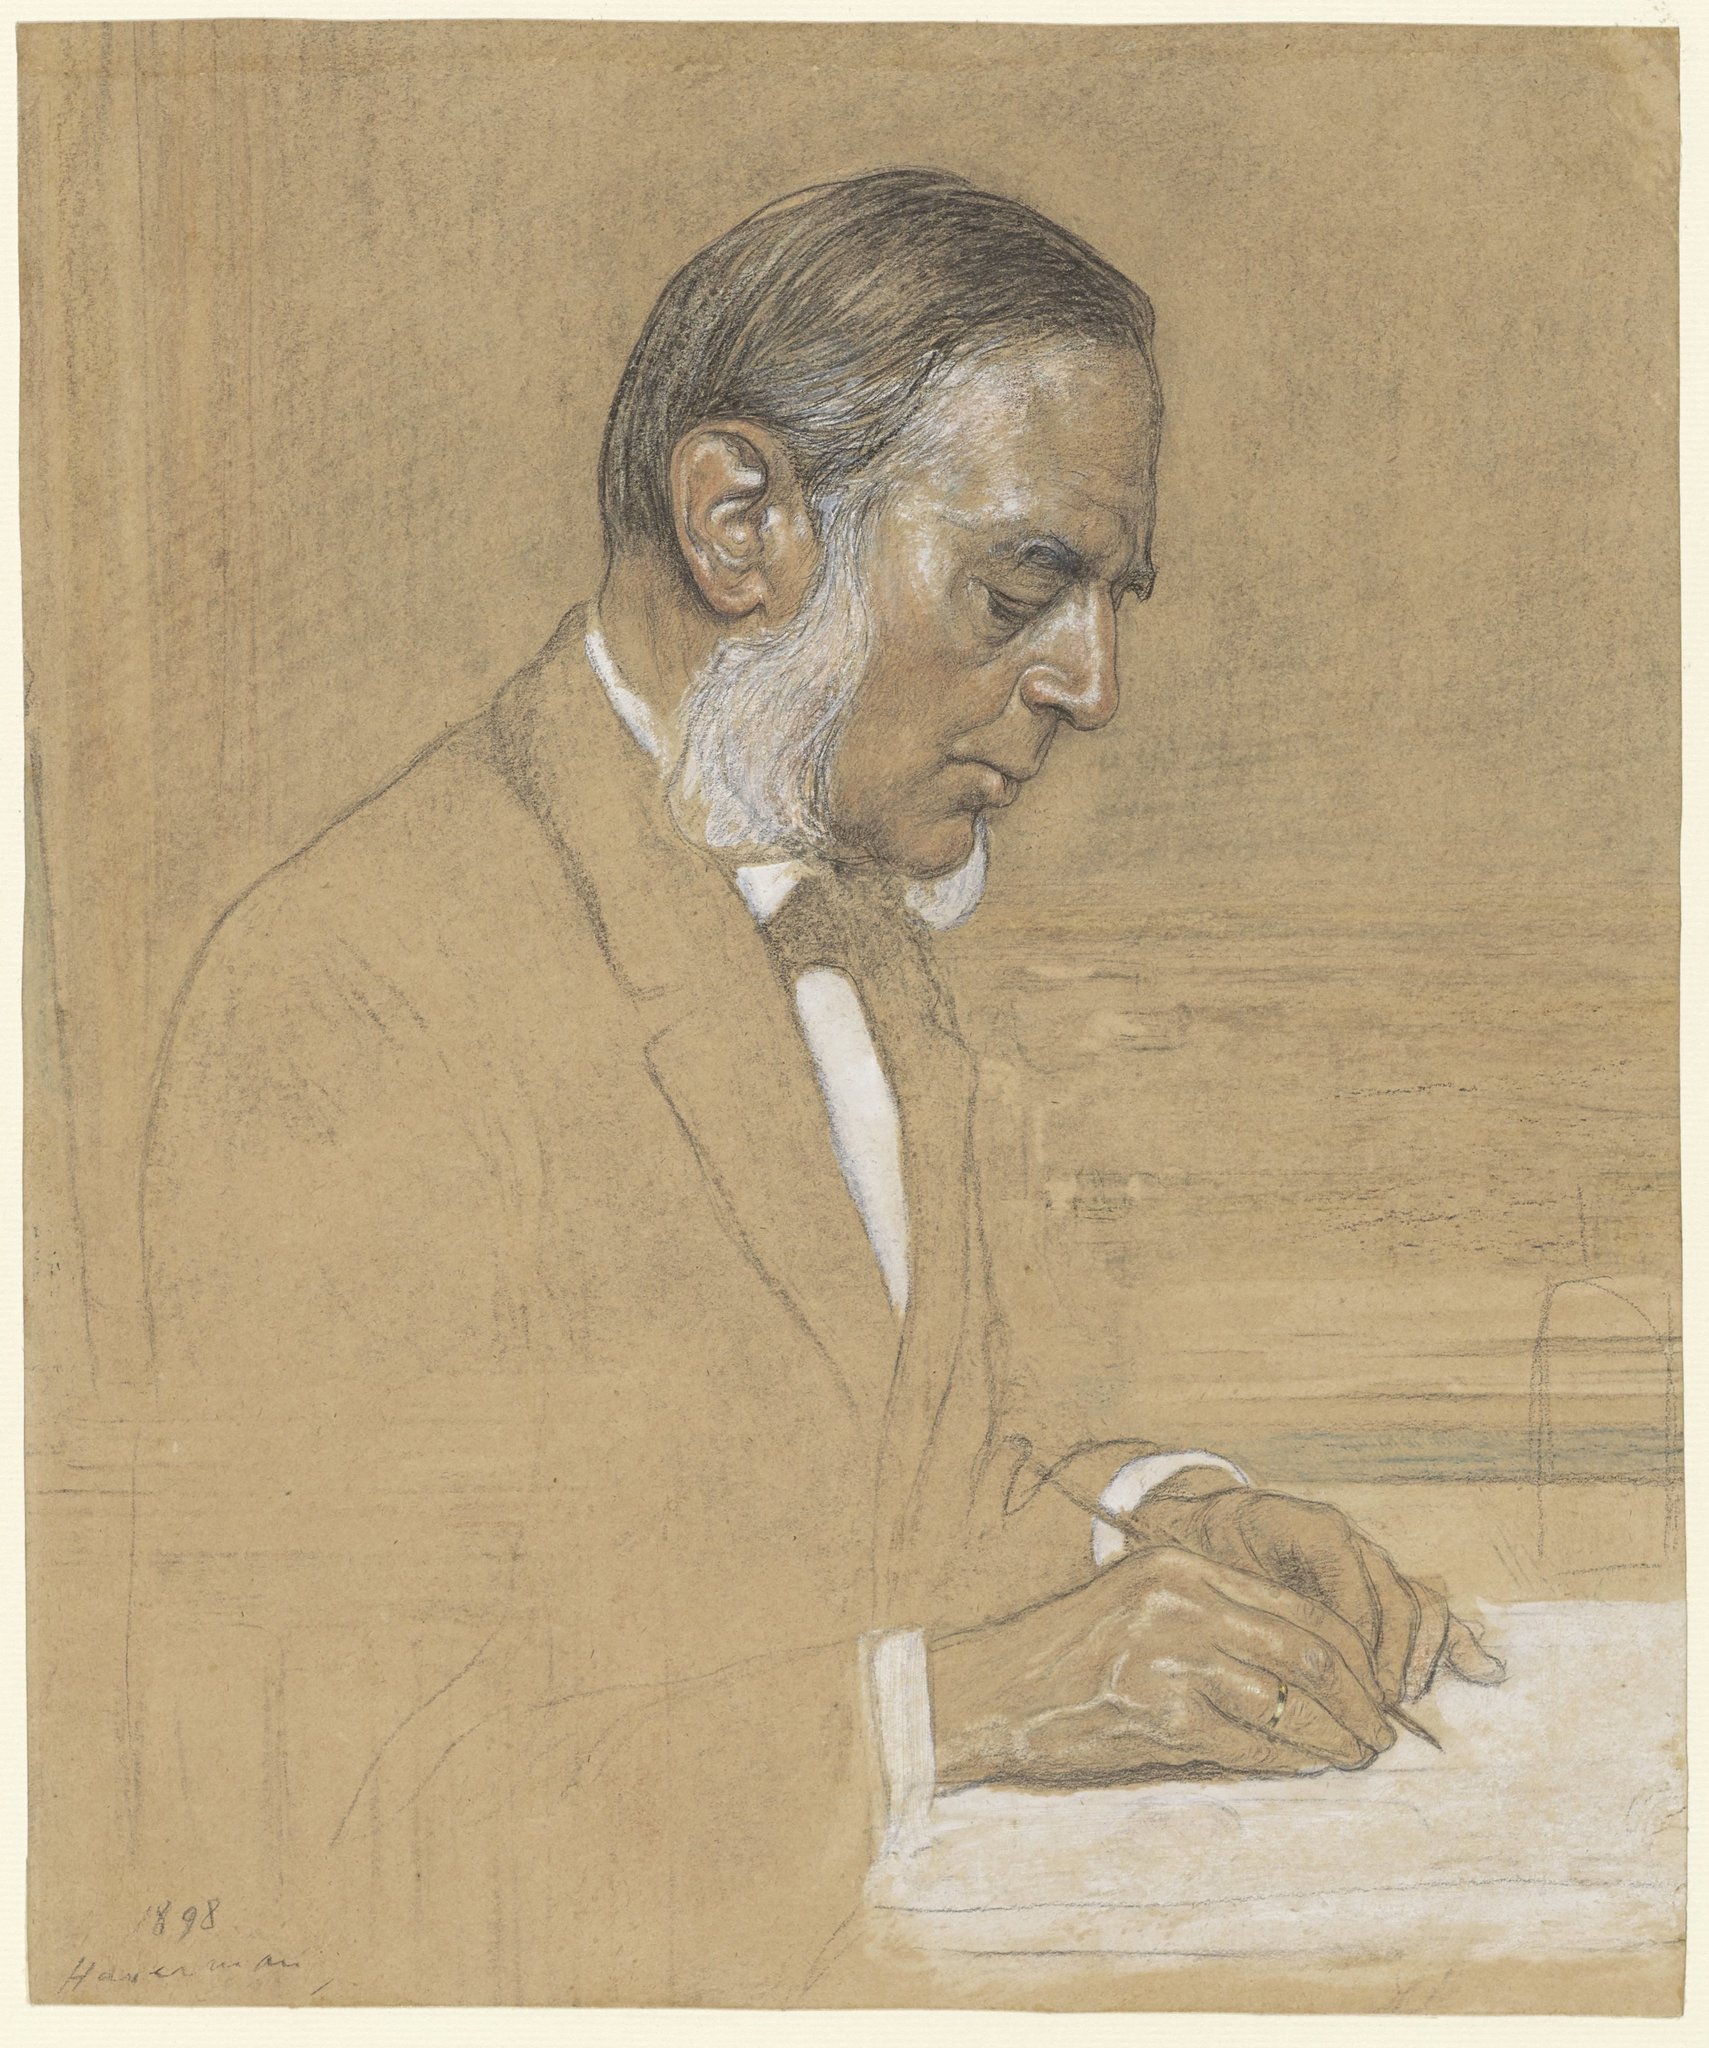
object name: drawing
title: Portret van Sjoerd Anne Vening Meinesz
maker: hendrik johannes haverman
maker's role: draughtsman, print maker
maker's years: 1857-1928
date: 1898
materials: chalk, paint, paper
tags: harlingen, politician, historical persons